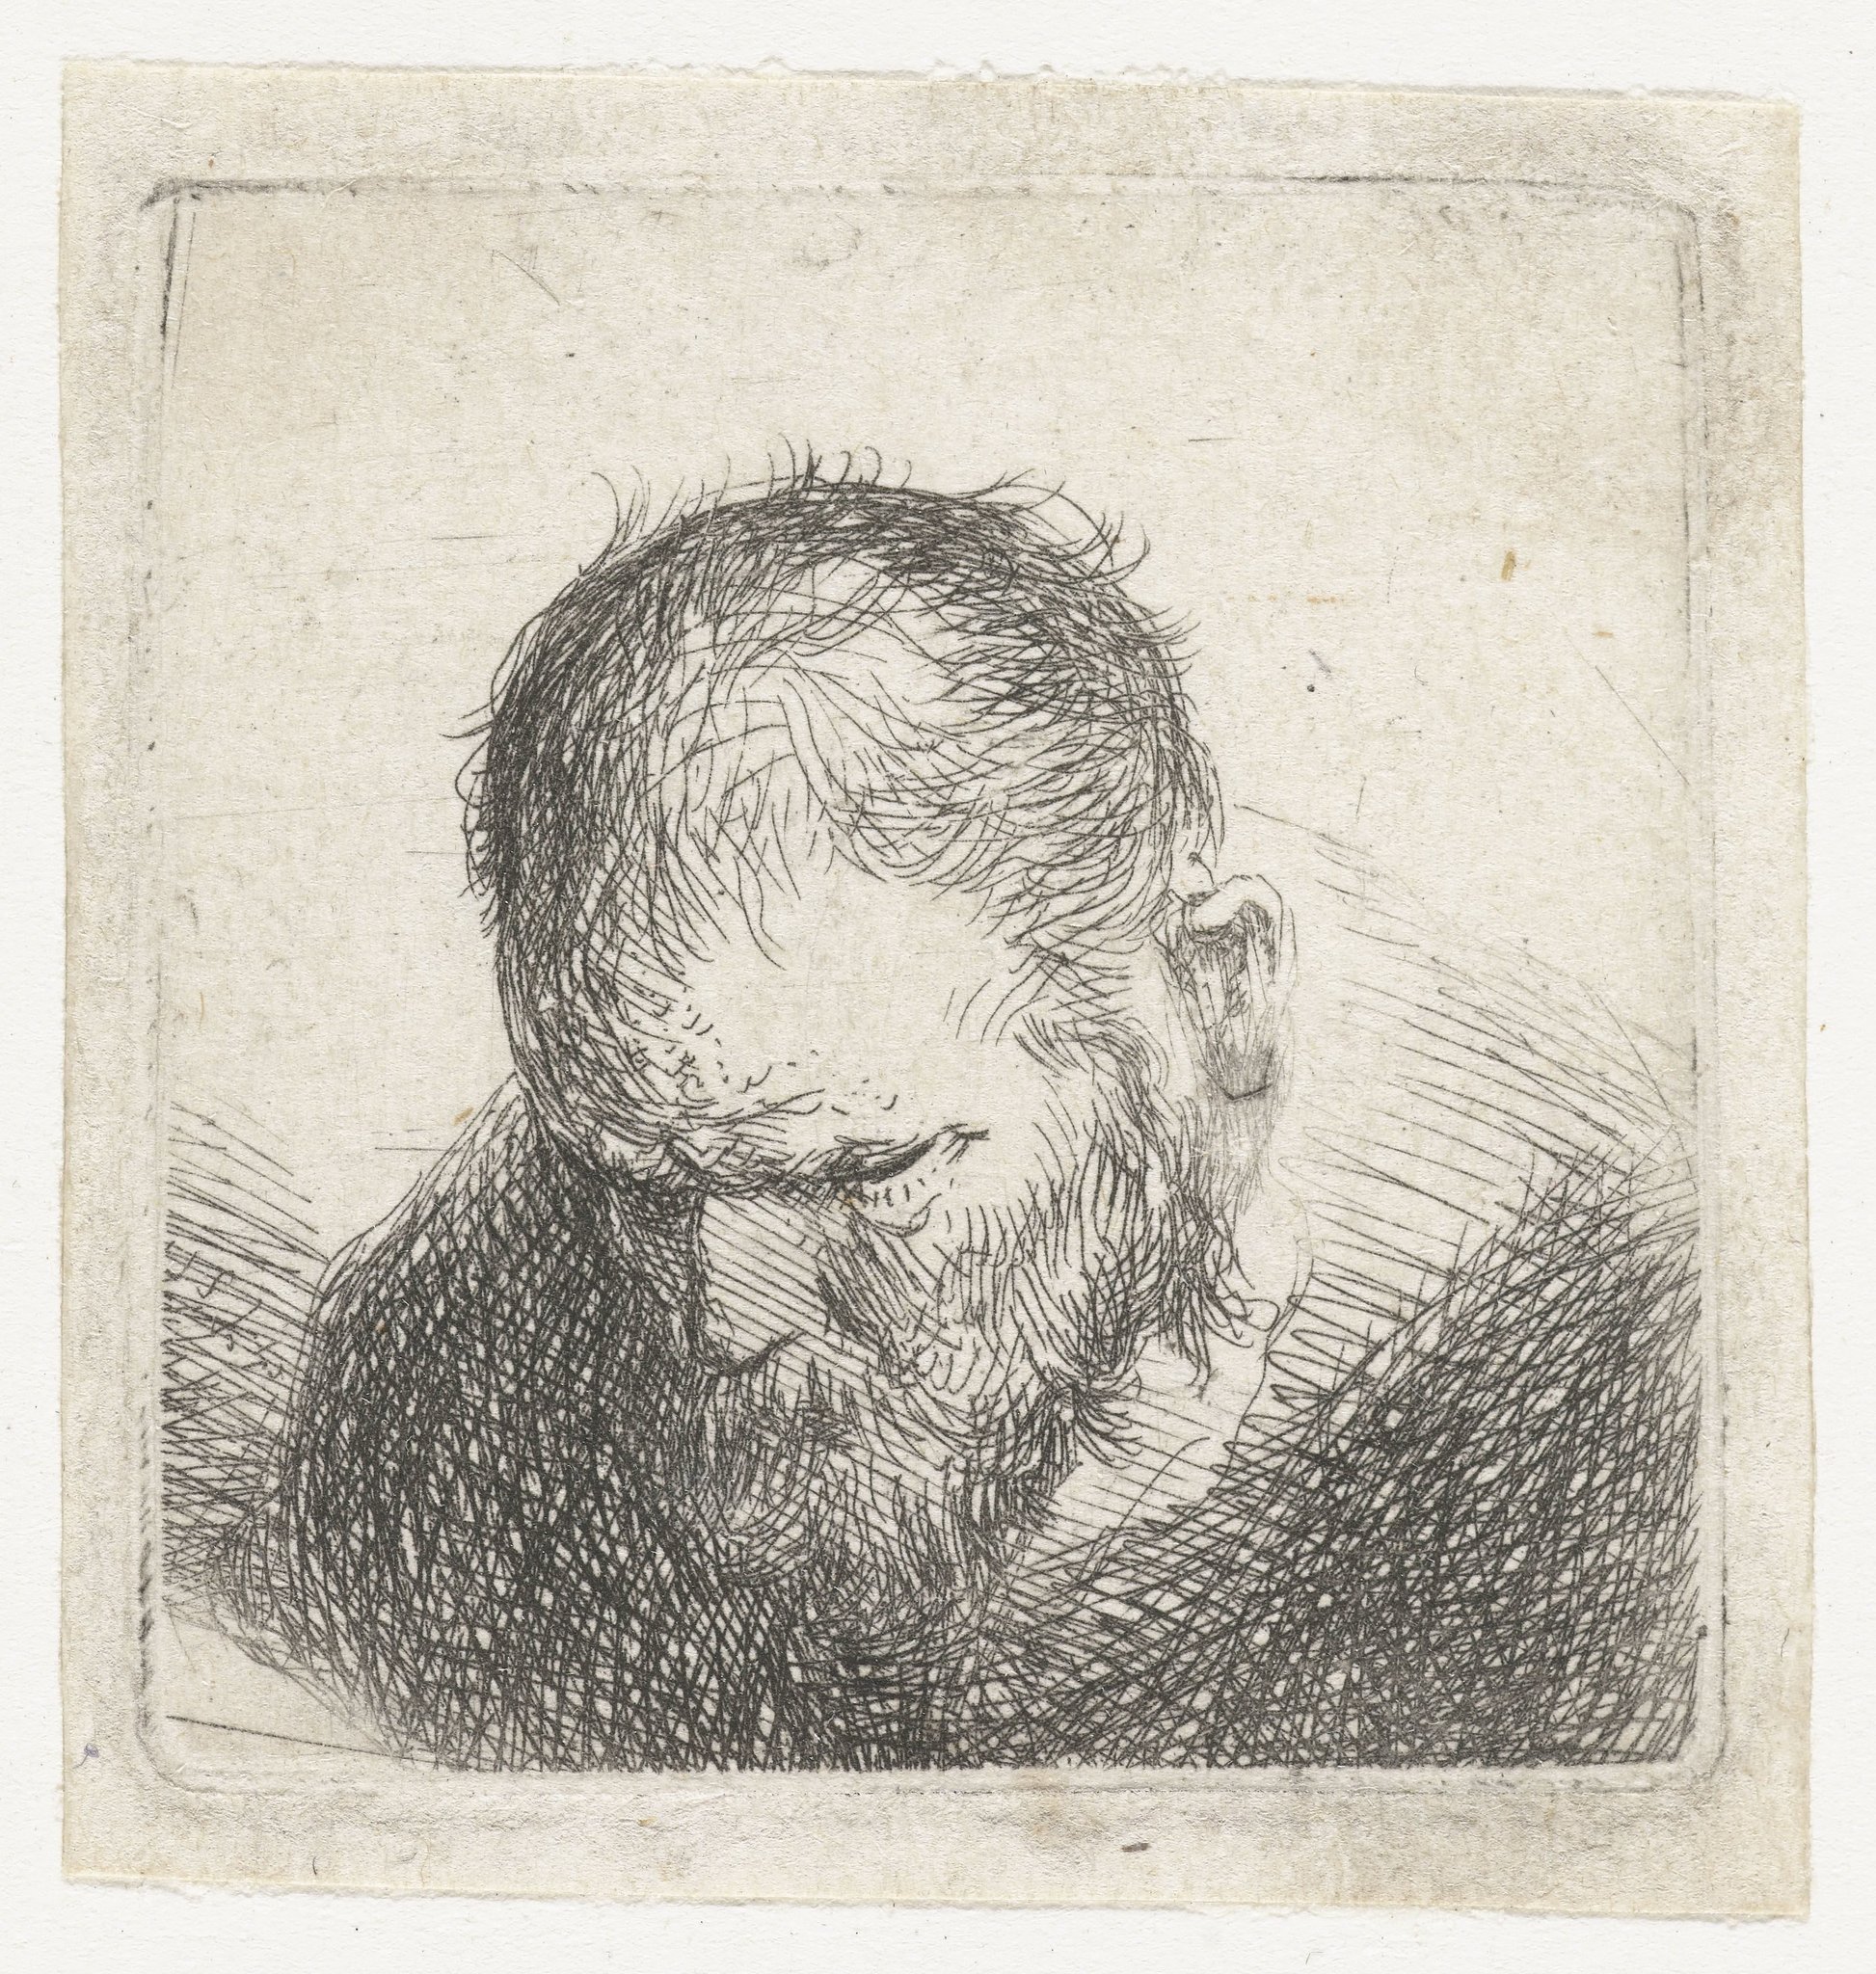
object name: print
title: Man met baard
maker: jan lievens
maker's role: draughtsman, painter, print maker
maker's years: 1607-1674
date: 1620-1700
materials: paper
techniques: drypoint, etching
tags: morphology of human expression (+ downward)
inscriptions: collector's mark: Lugt 240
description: Man met een baard, kijkend naar beneden.